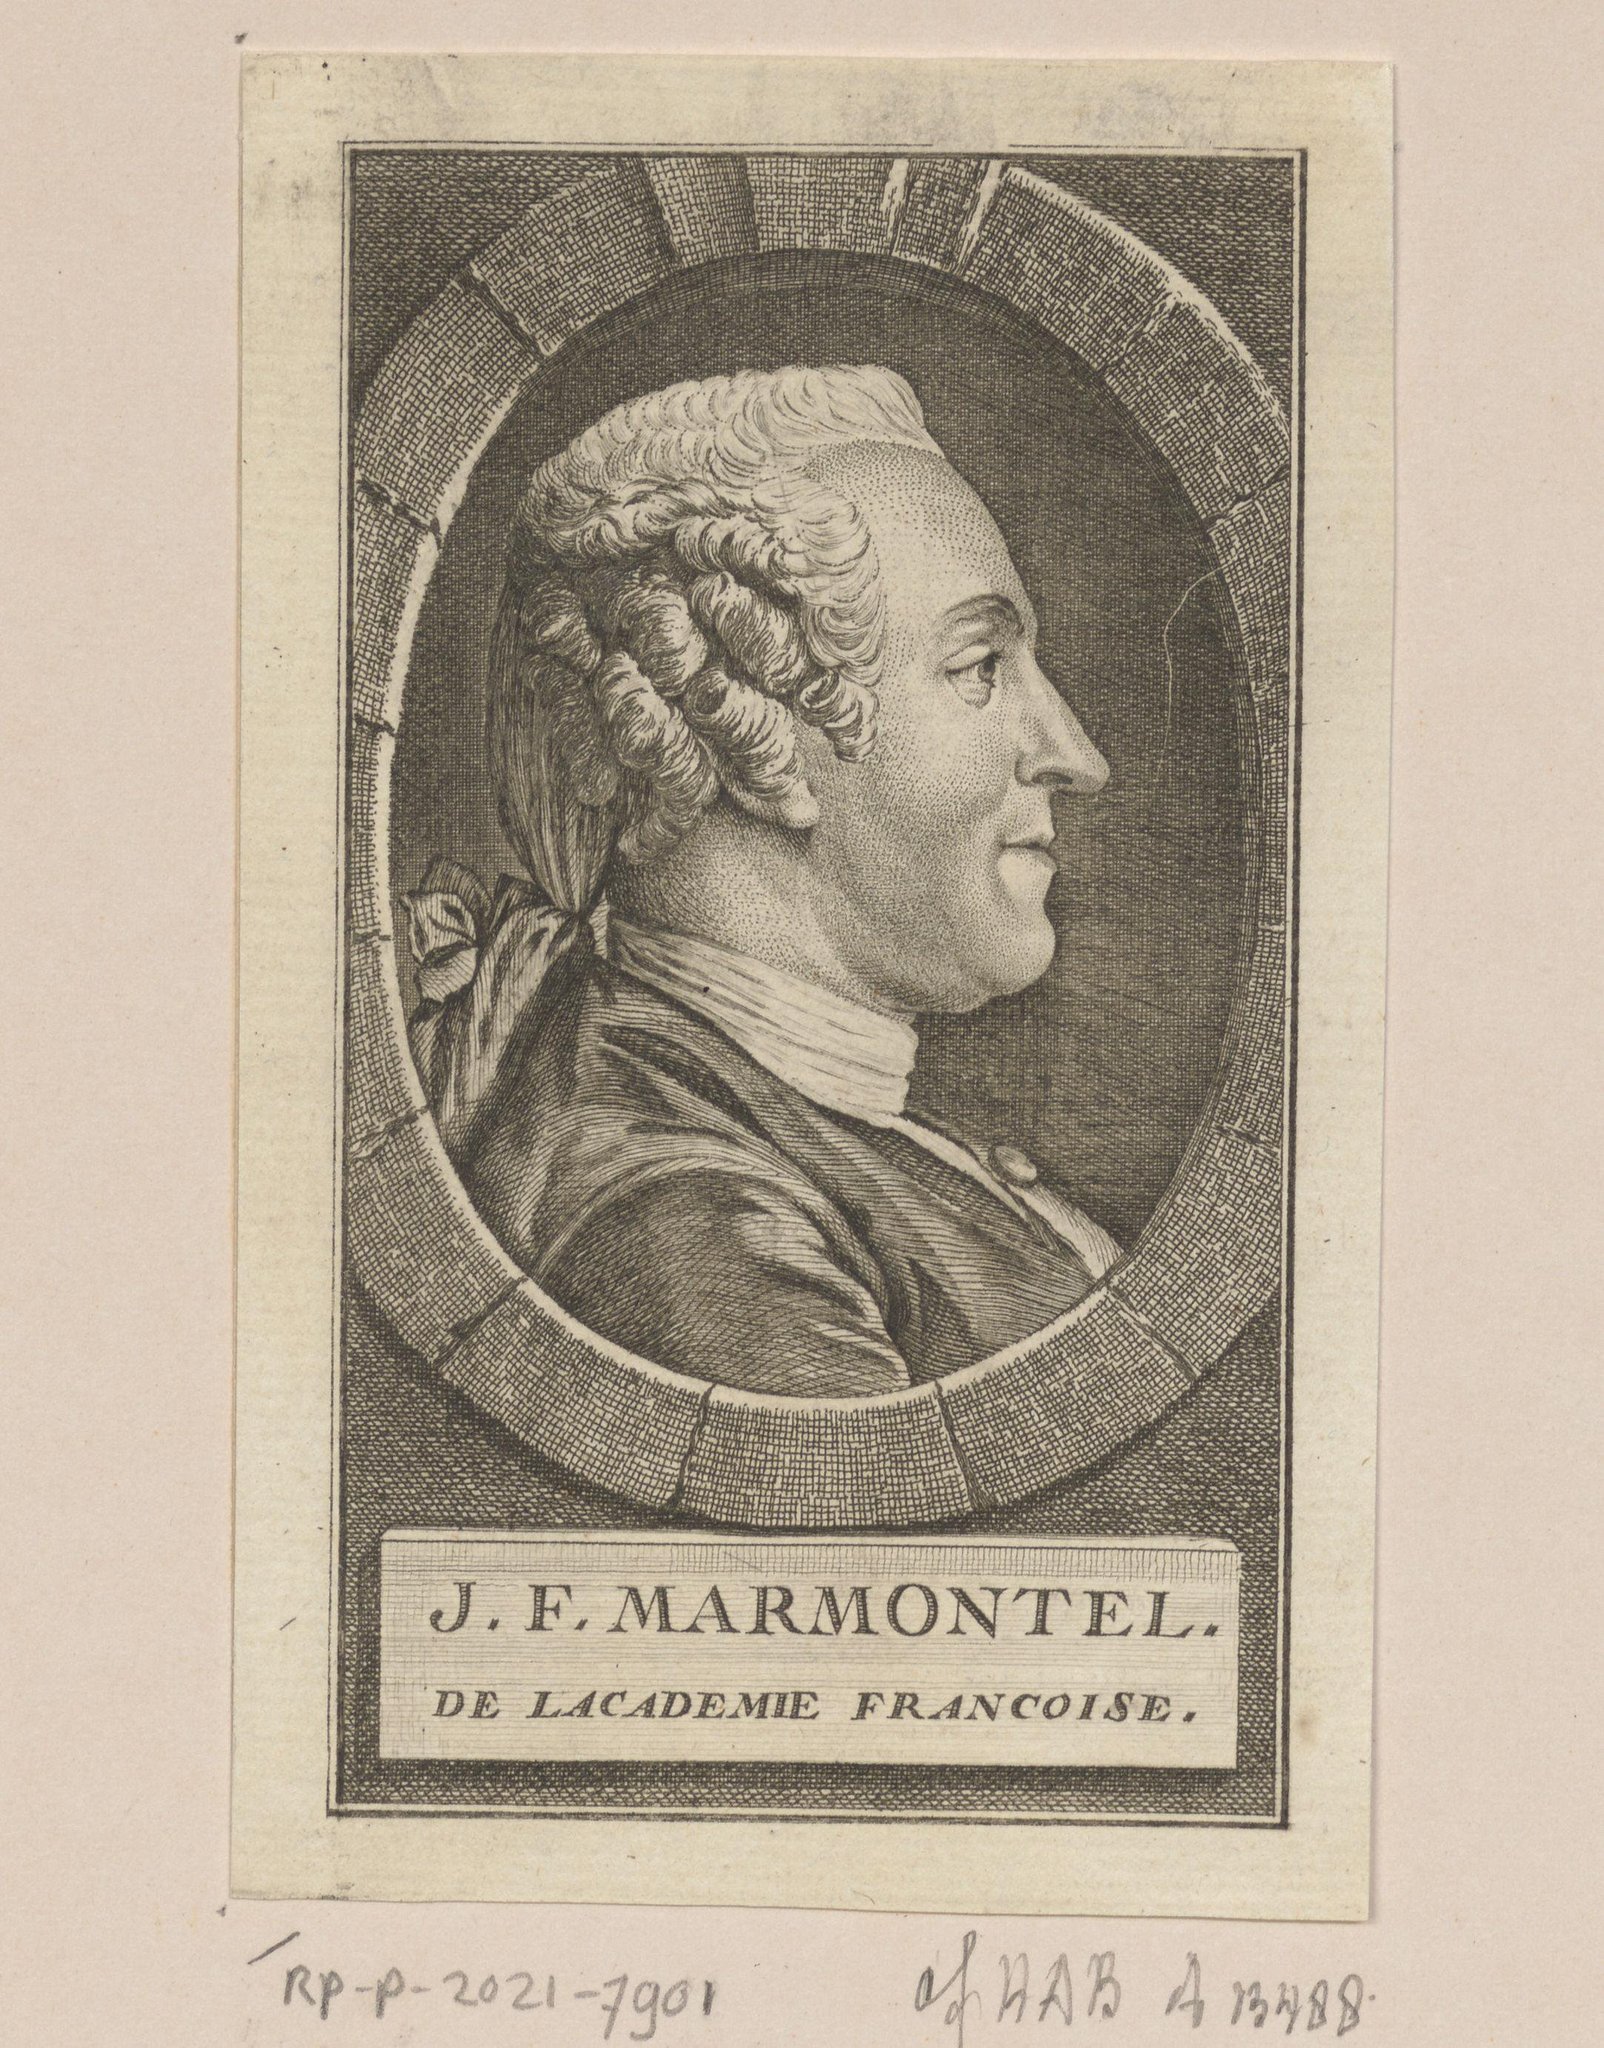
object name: print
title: Portret van Jean-François Marmontel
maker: Anonymous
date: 1774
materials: paper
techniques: etching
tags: jean françois marmontel, ornament ~ medallion, historical persons, portrait of a writer, wig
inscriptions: number: ‘1635’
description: Andere staat van prent gebruikt in: Marmontel, Jean François. Contes moraux. Den Haag: s.n., 1774, dl. 1.